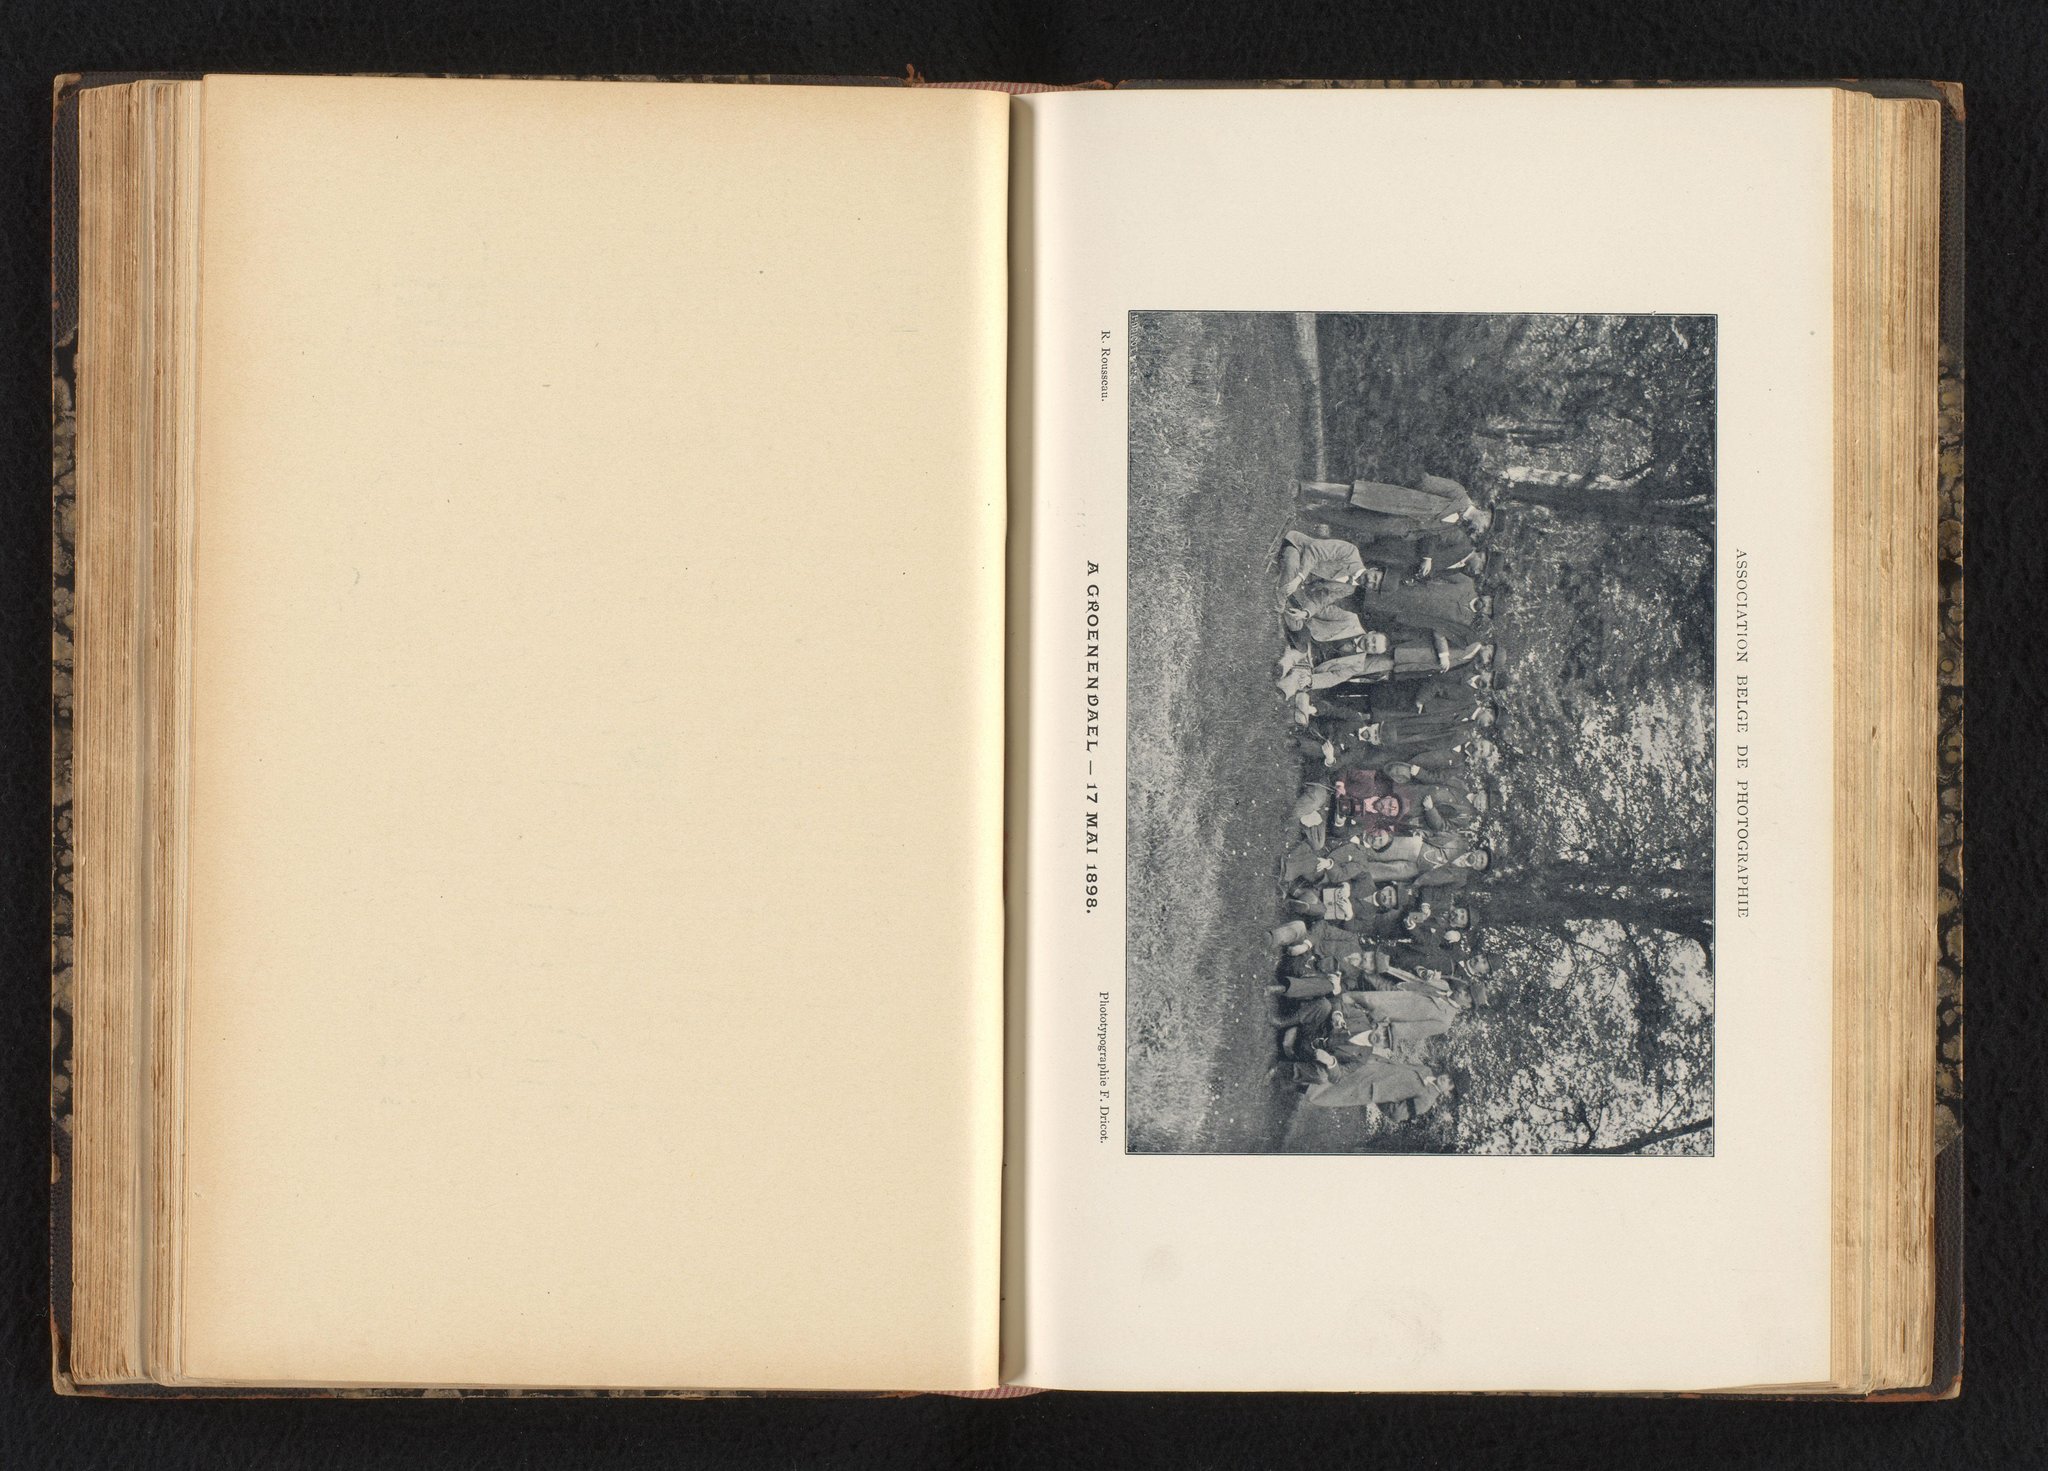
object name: page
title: Groepsportret van onbekende mannen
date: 1898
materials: paper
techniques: autotype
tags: adult man, anonymous historical persons portrayed in a group, in a group-portrait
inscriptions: inscription: ‘Association belge de photographie’